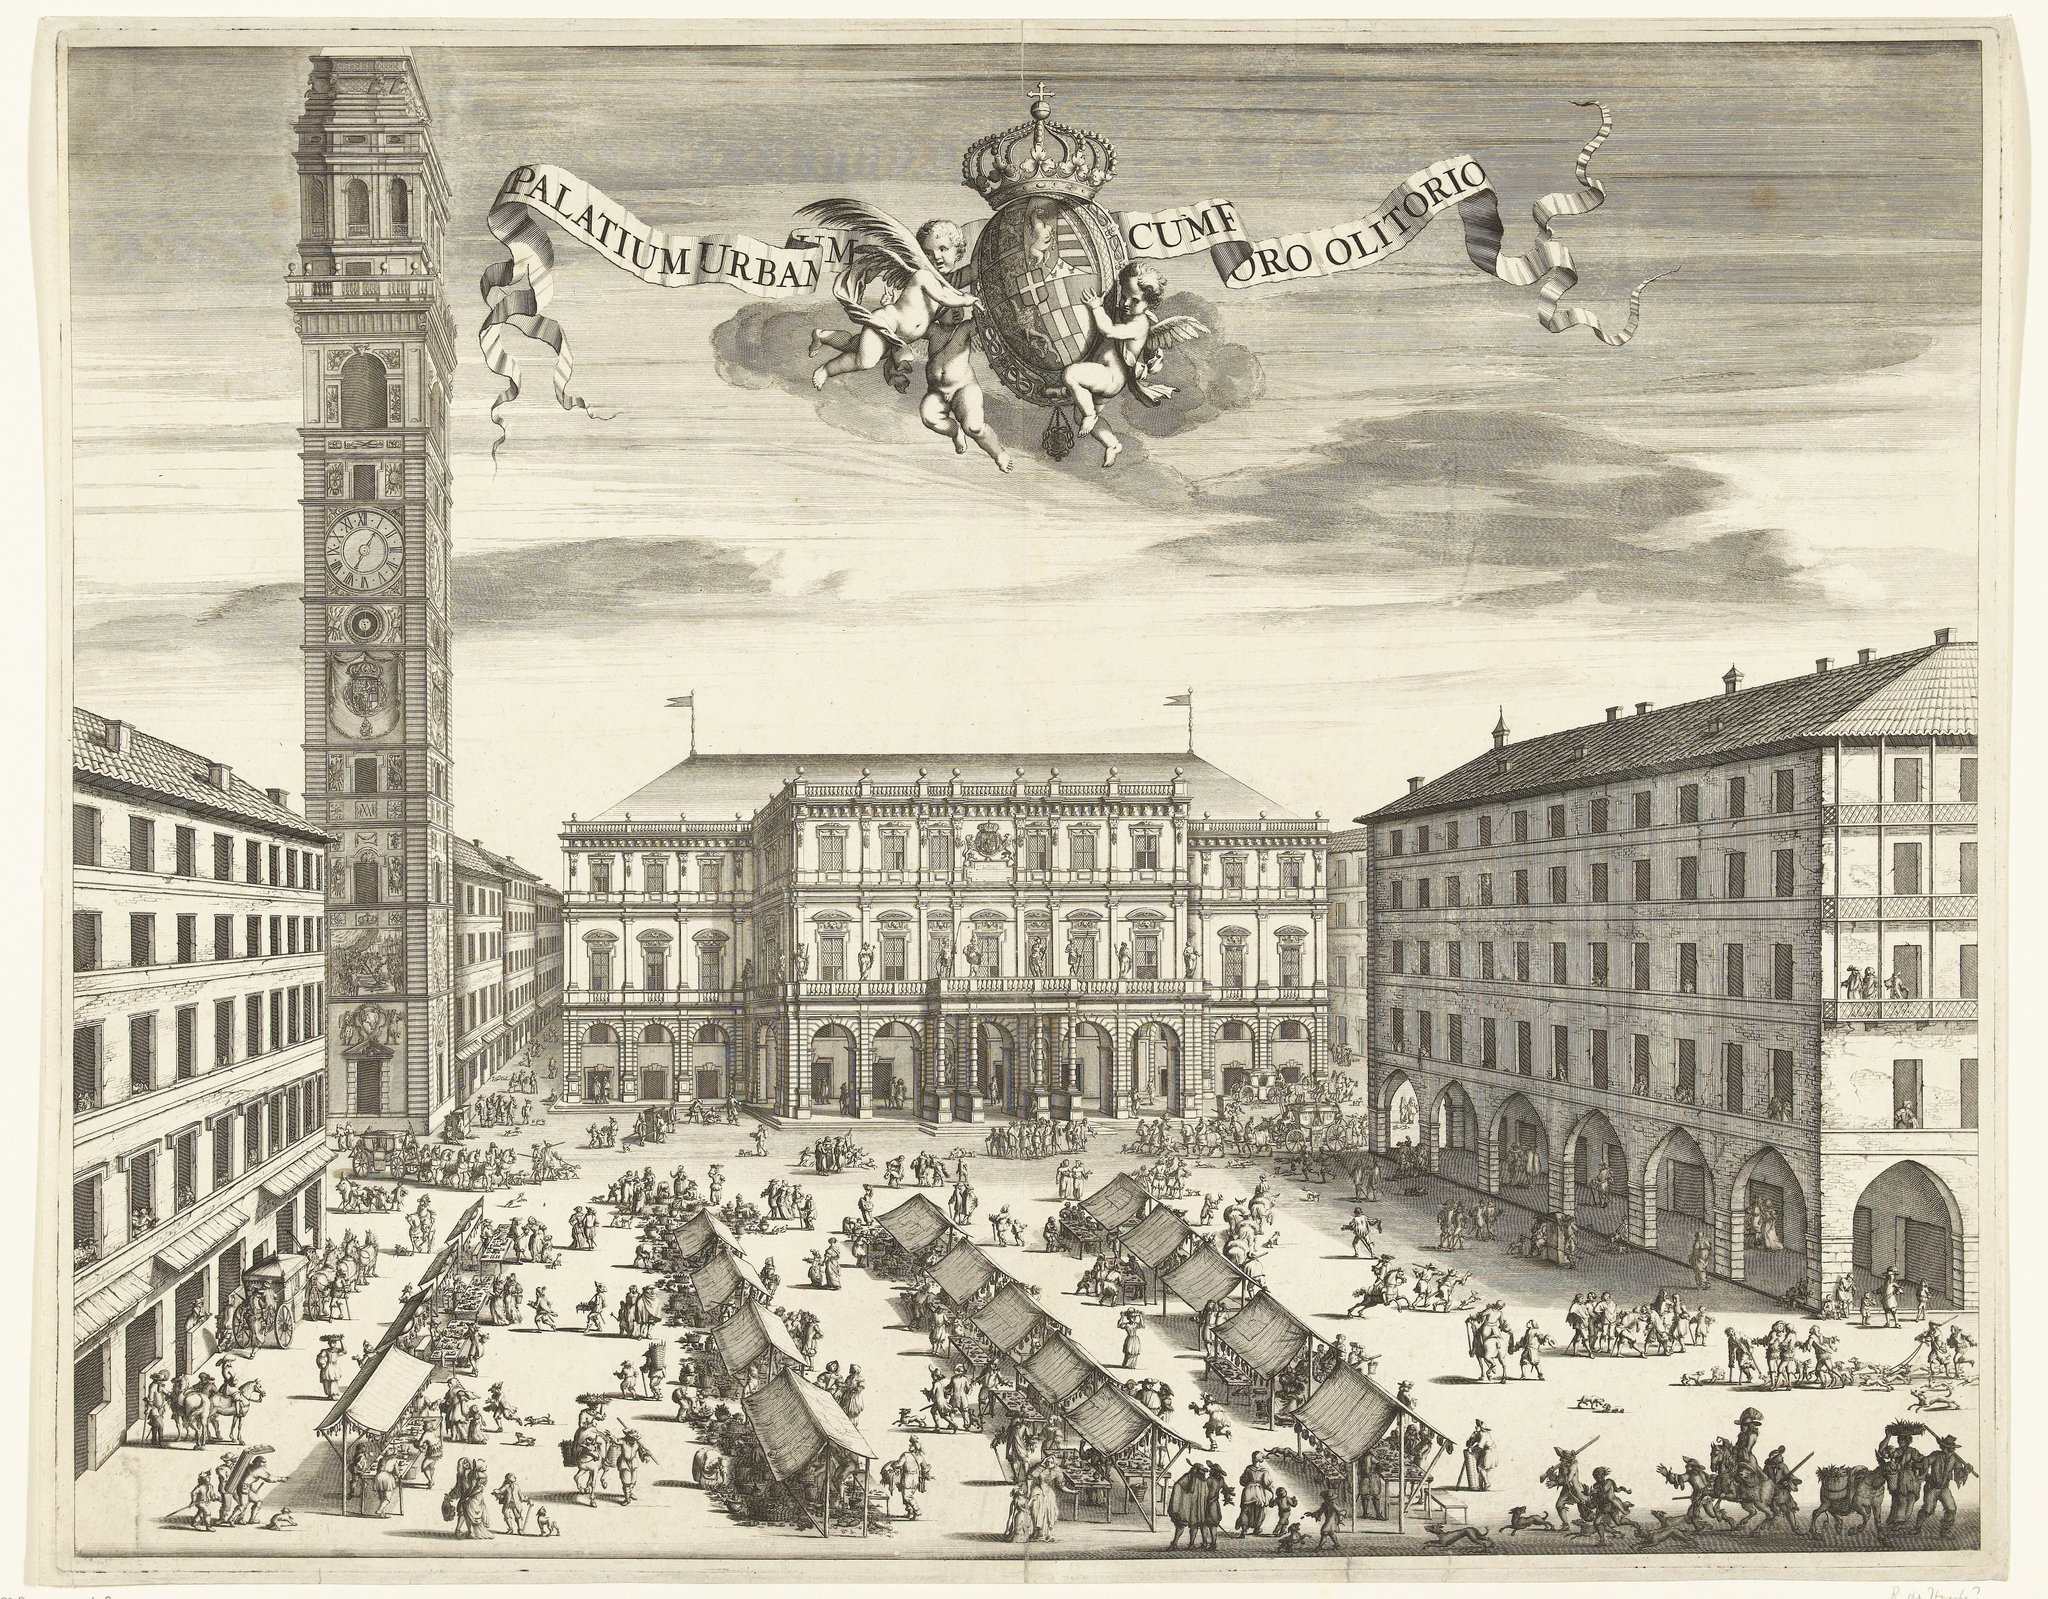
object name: print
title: Gezicht op het Piazza Palazzo di Città (Piazza delle Erbe) met het stadhuis in Turijn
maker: romeyn de hooghe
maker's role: draughtsman, goldsmith, painter, print maker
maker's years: 1645-1708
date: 1681-1682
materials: paper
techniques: etching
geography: netherlands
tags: square, place, circus, etc., townhall, market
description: Gezicht op het Piazza Palazzo di Città (Piazza delle Erbe) met het stadhuis in Turijn. Op het plein staan marktkramen. In de lucht drie putti die een heraldisch wapen dragen. Aan weerzijden daarvan banderollen met de titel.